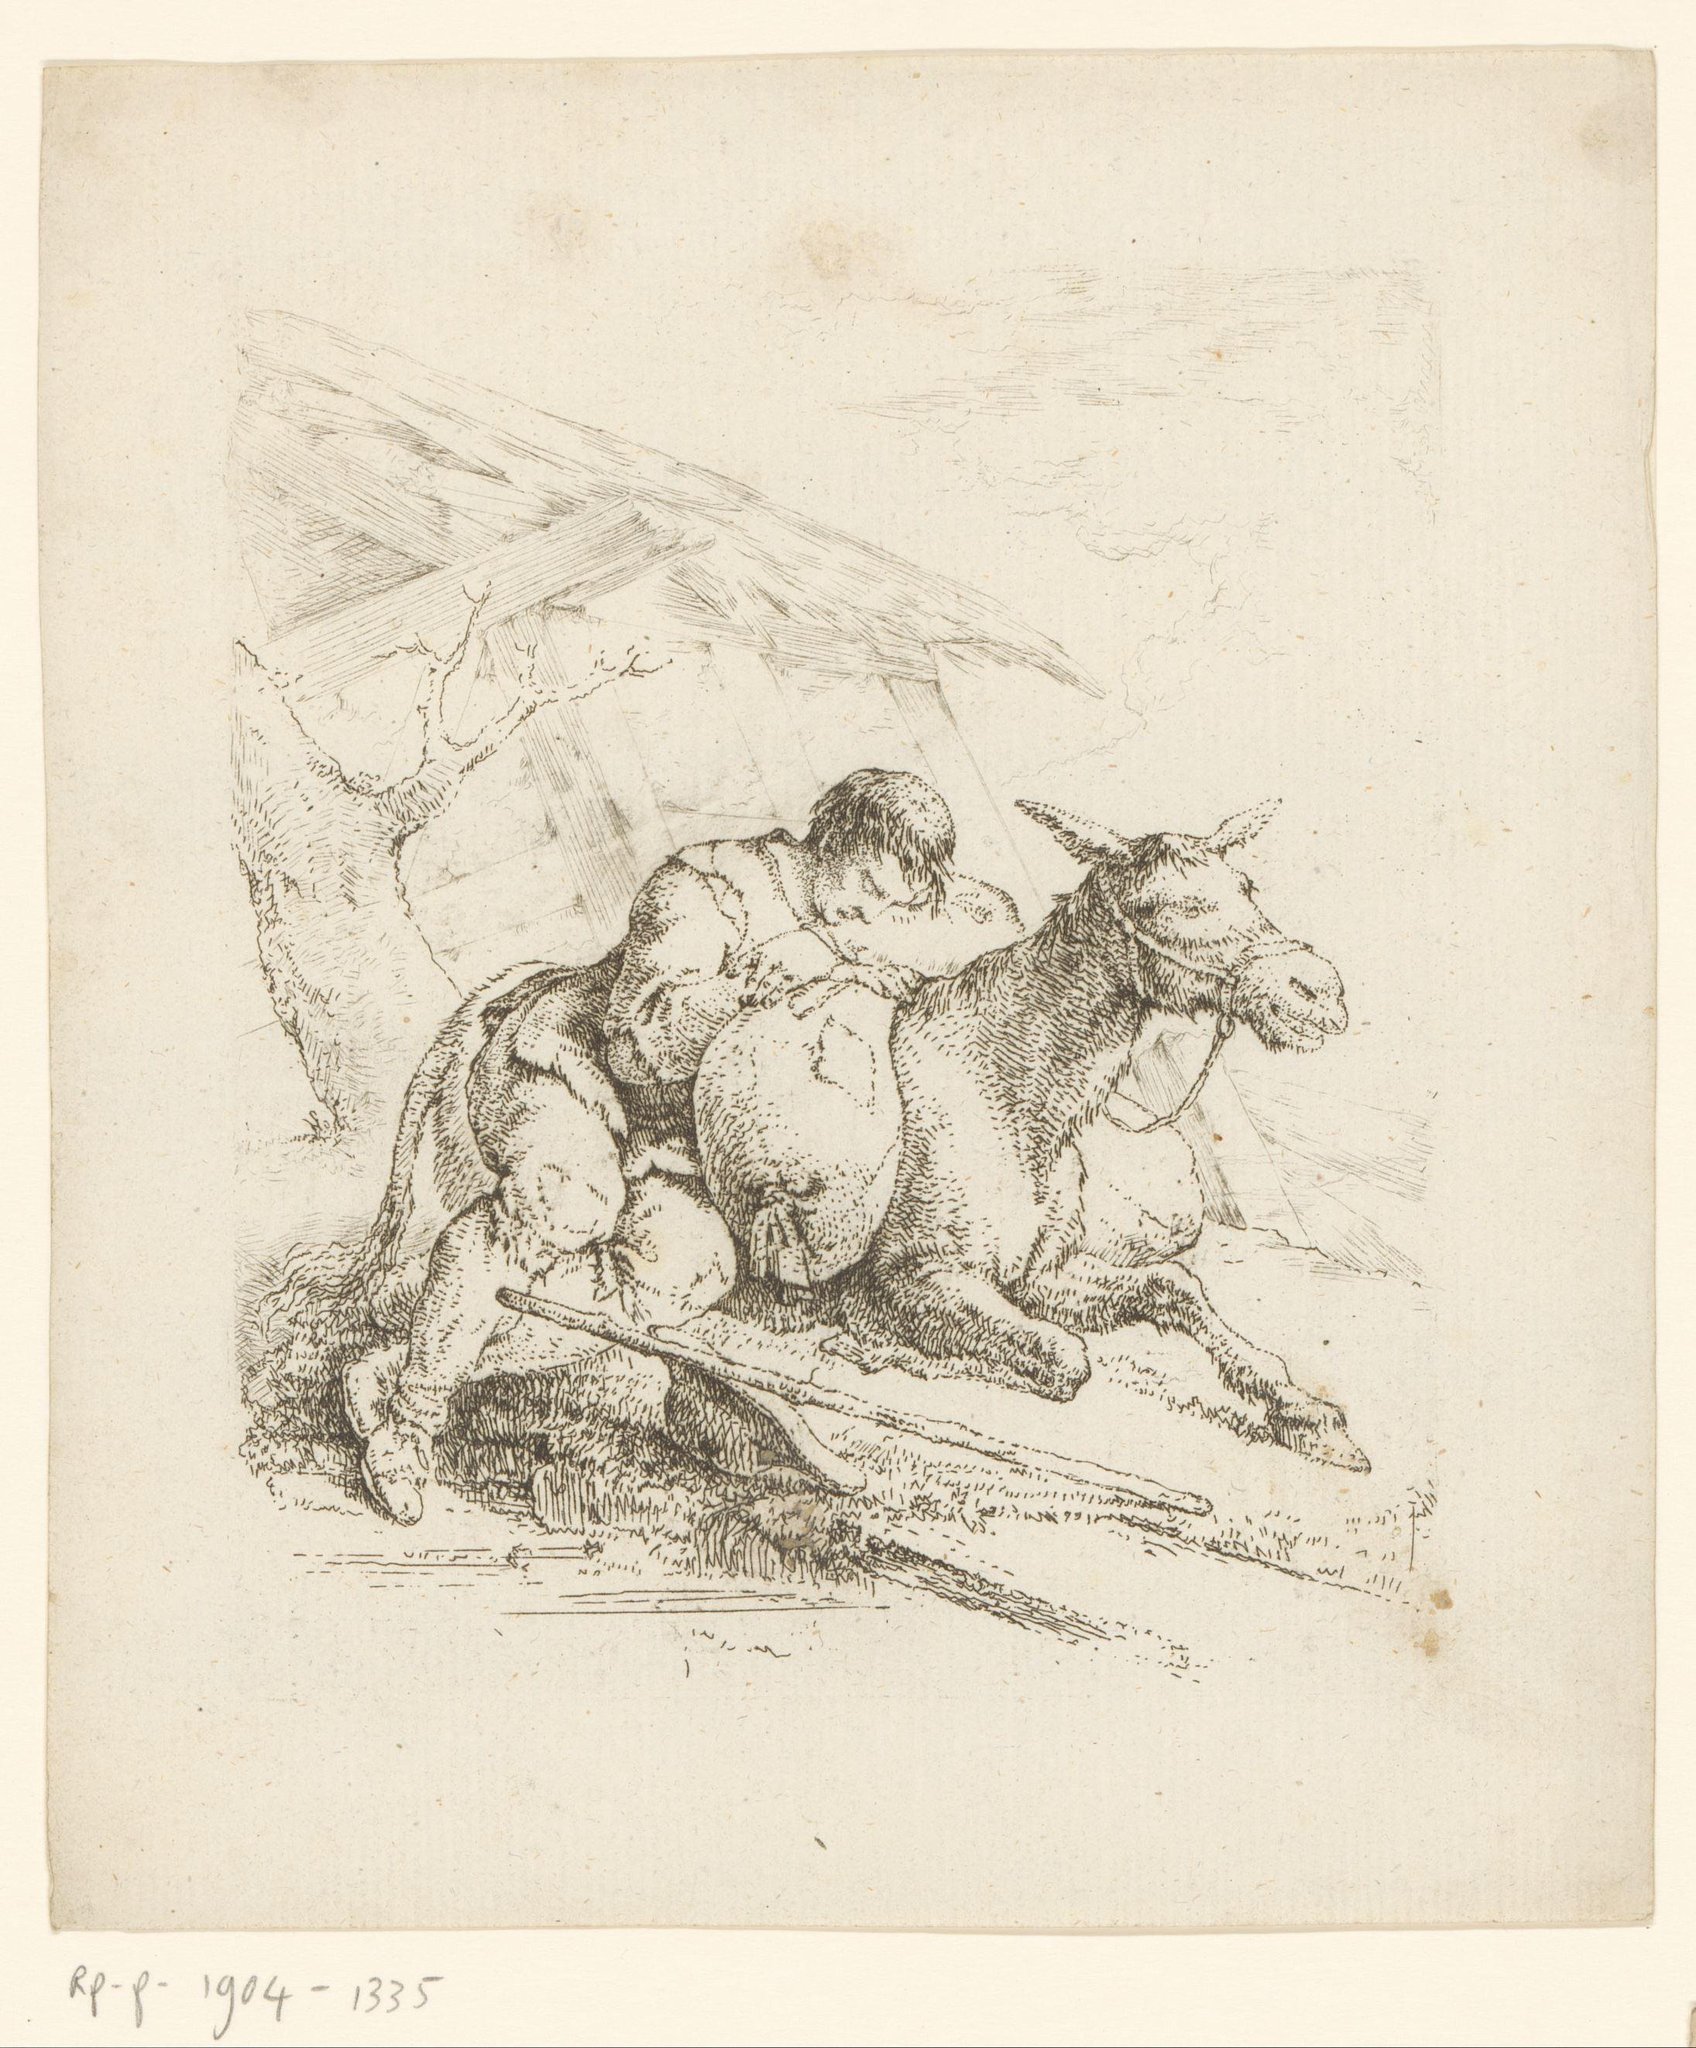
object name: print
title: Allegorie van de luiheid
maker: bernhard rode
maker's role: artist, print maker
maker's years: 1725-1797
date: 1788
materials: paper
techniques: etching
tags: idleness; 'otio' (ripa), ass, donkey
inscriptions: collector's mark: Lugt 2228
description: Prent ook gebruikt in: Ramler, Karl Wilhelm. Allegorische Personen zum Gebrauche der bildenden Künstler. Berlijn: Akademischen Kunst- und Buchhandlung, 1788.